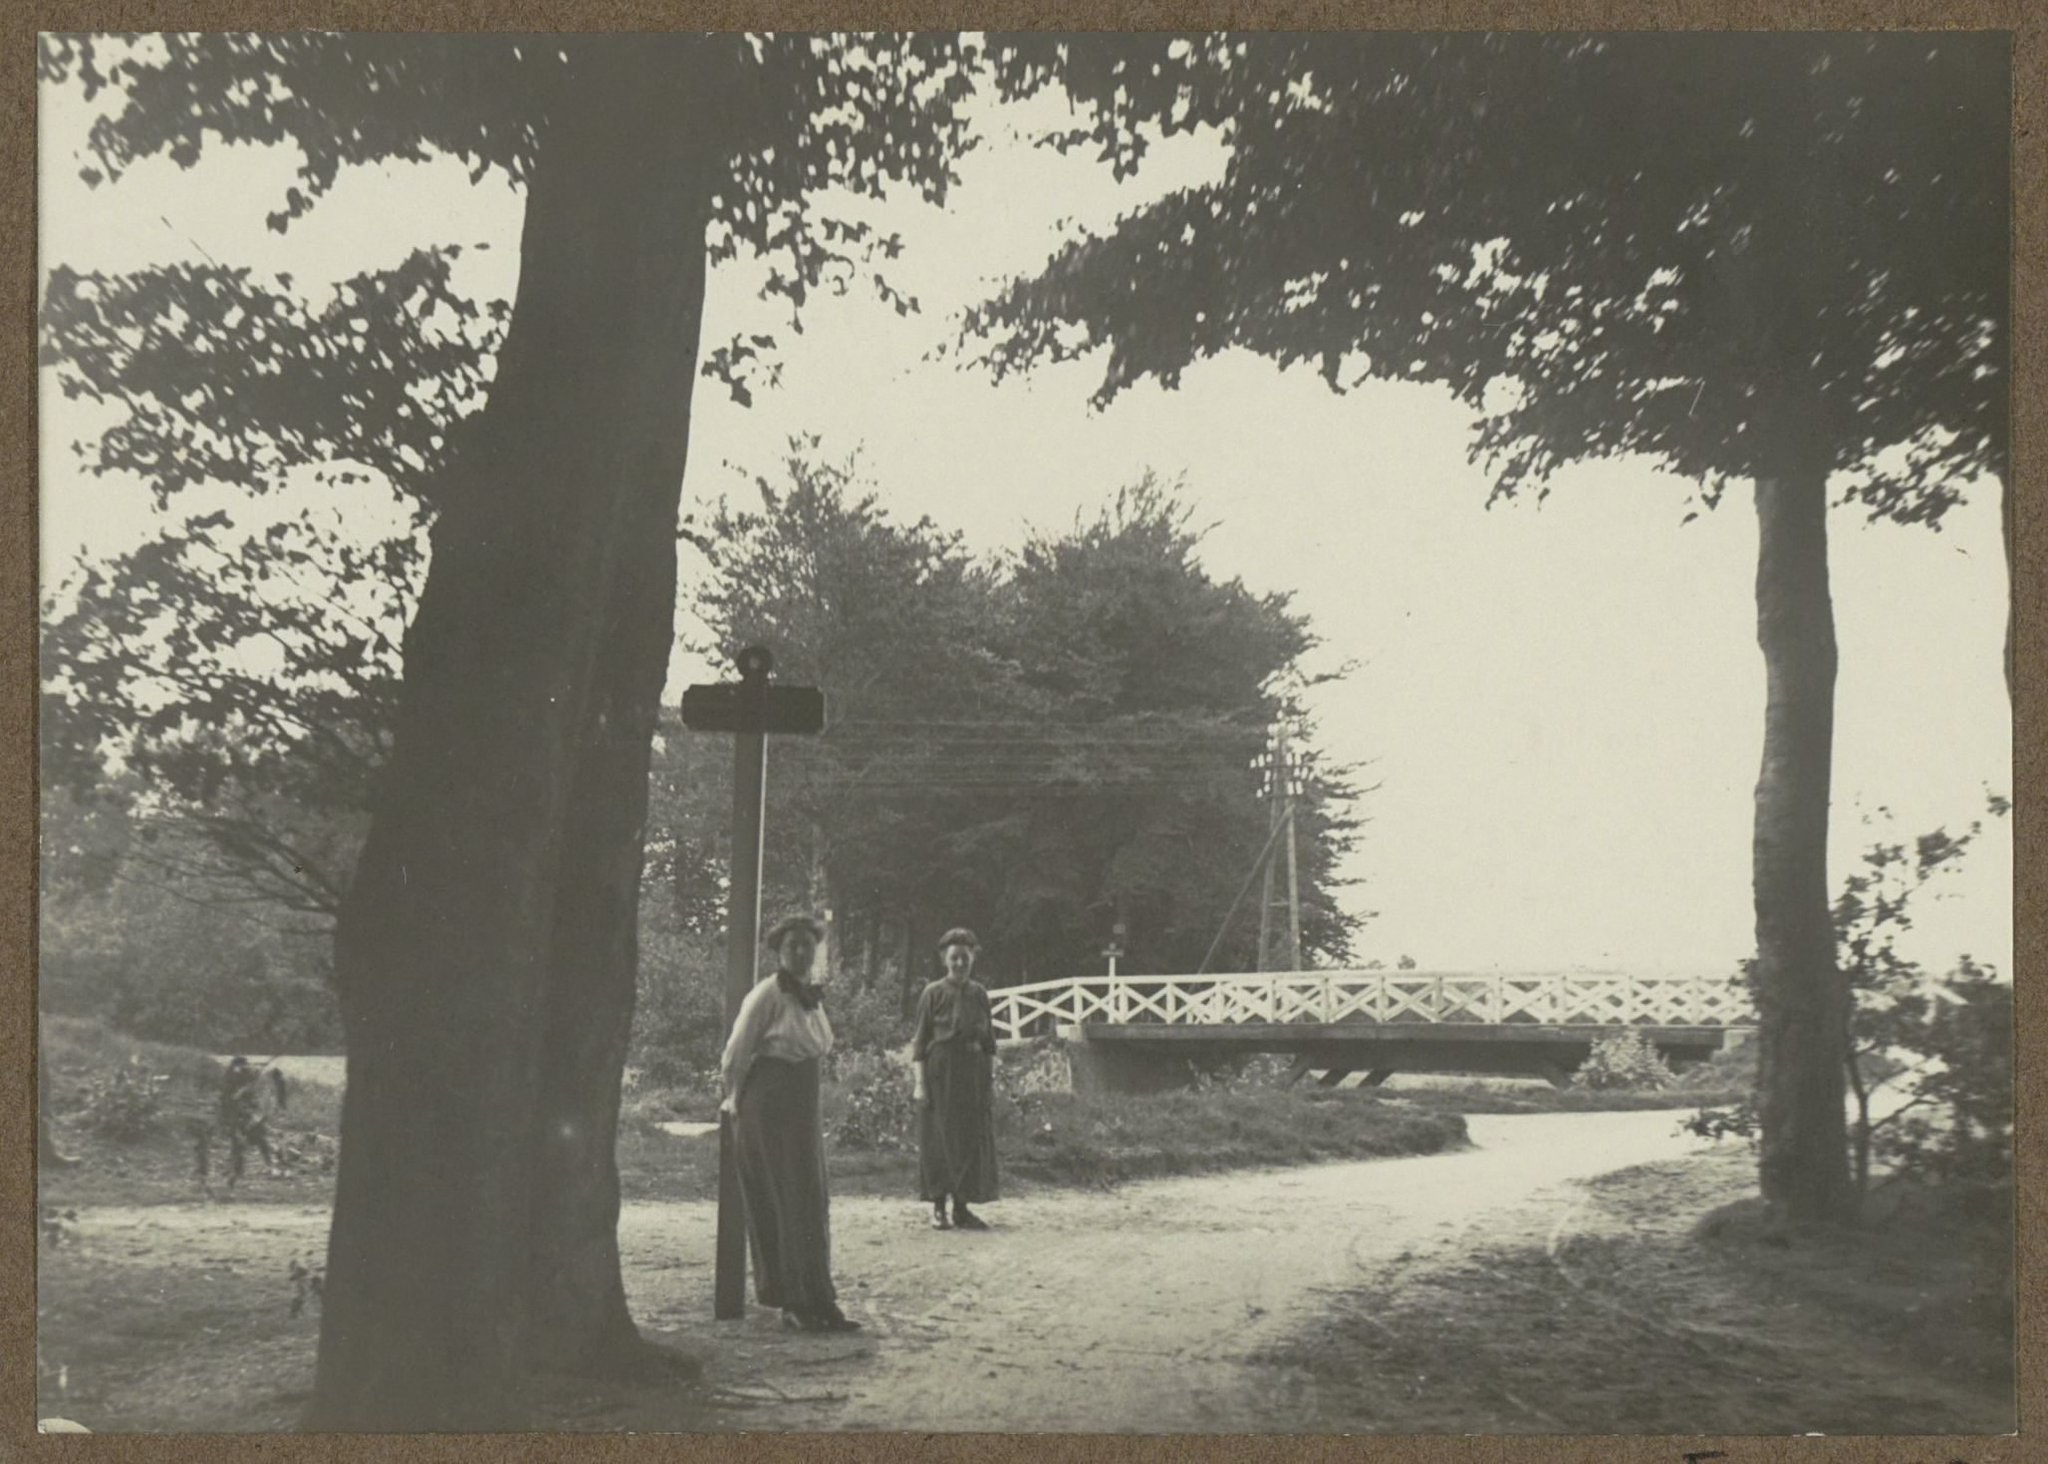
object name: photograph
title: Twee vrouwen voor een brug op landgoed Zwaluwenberg bij Hilversum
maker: Anonymous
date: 1910-1930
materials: paper, photographic support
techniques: gelatin silver print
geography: hilversum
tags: bridge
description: Onderdeel van Album met foto's van Amsterdam en omgeving.